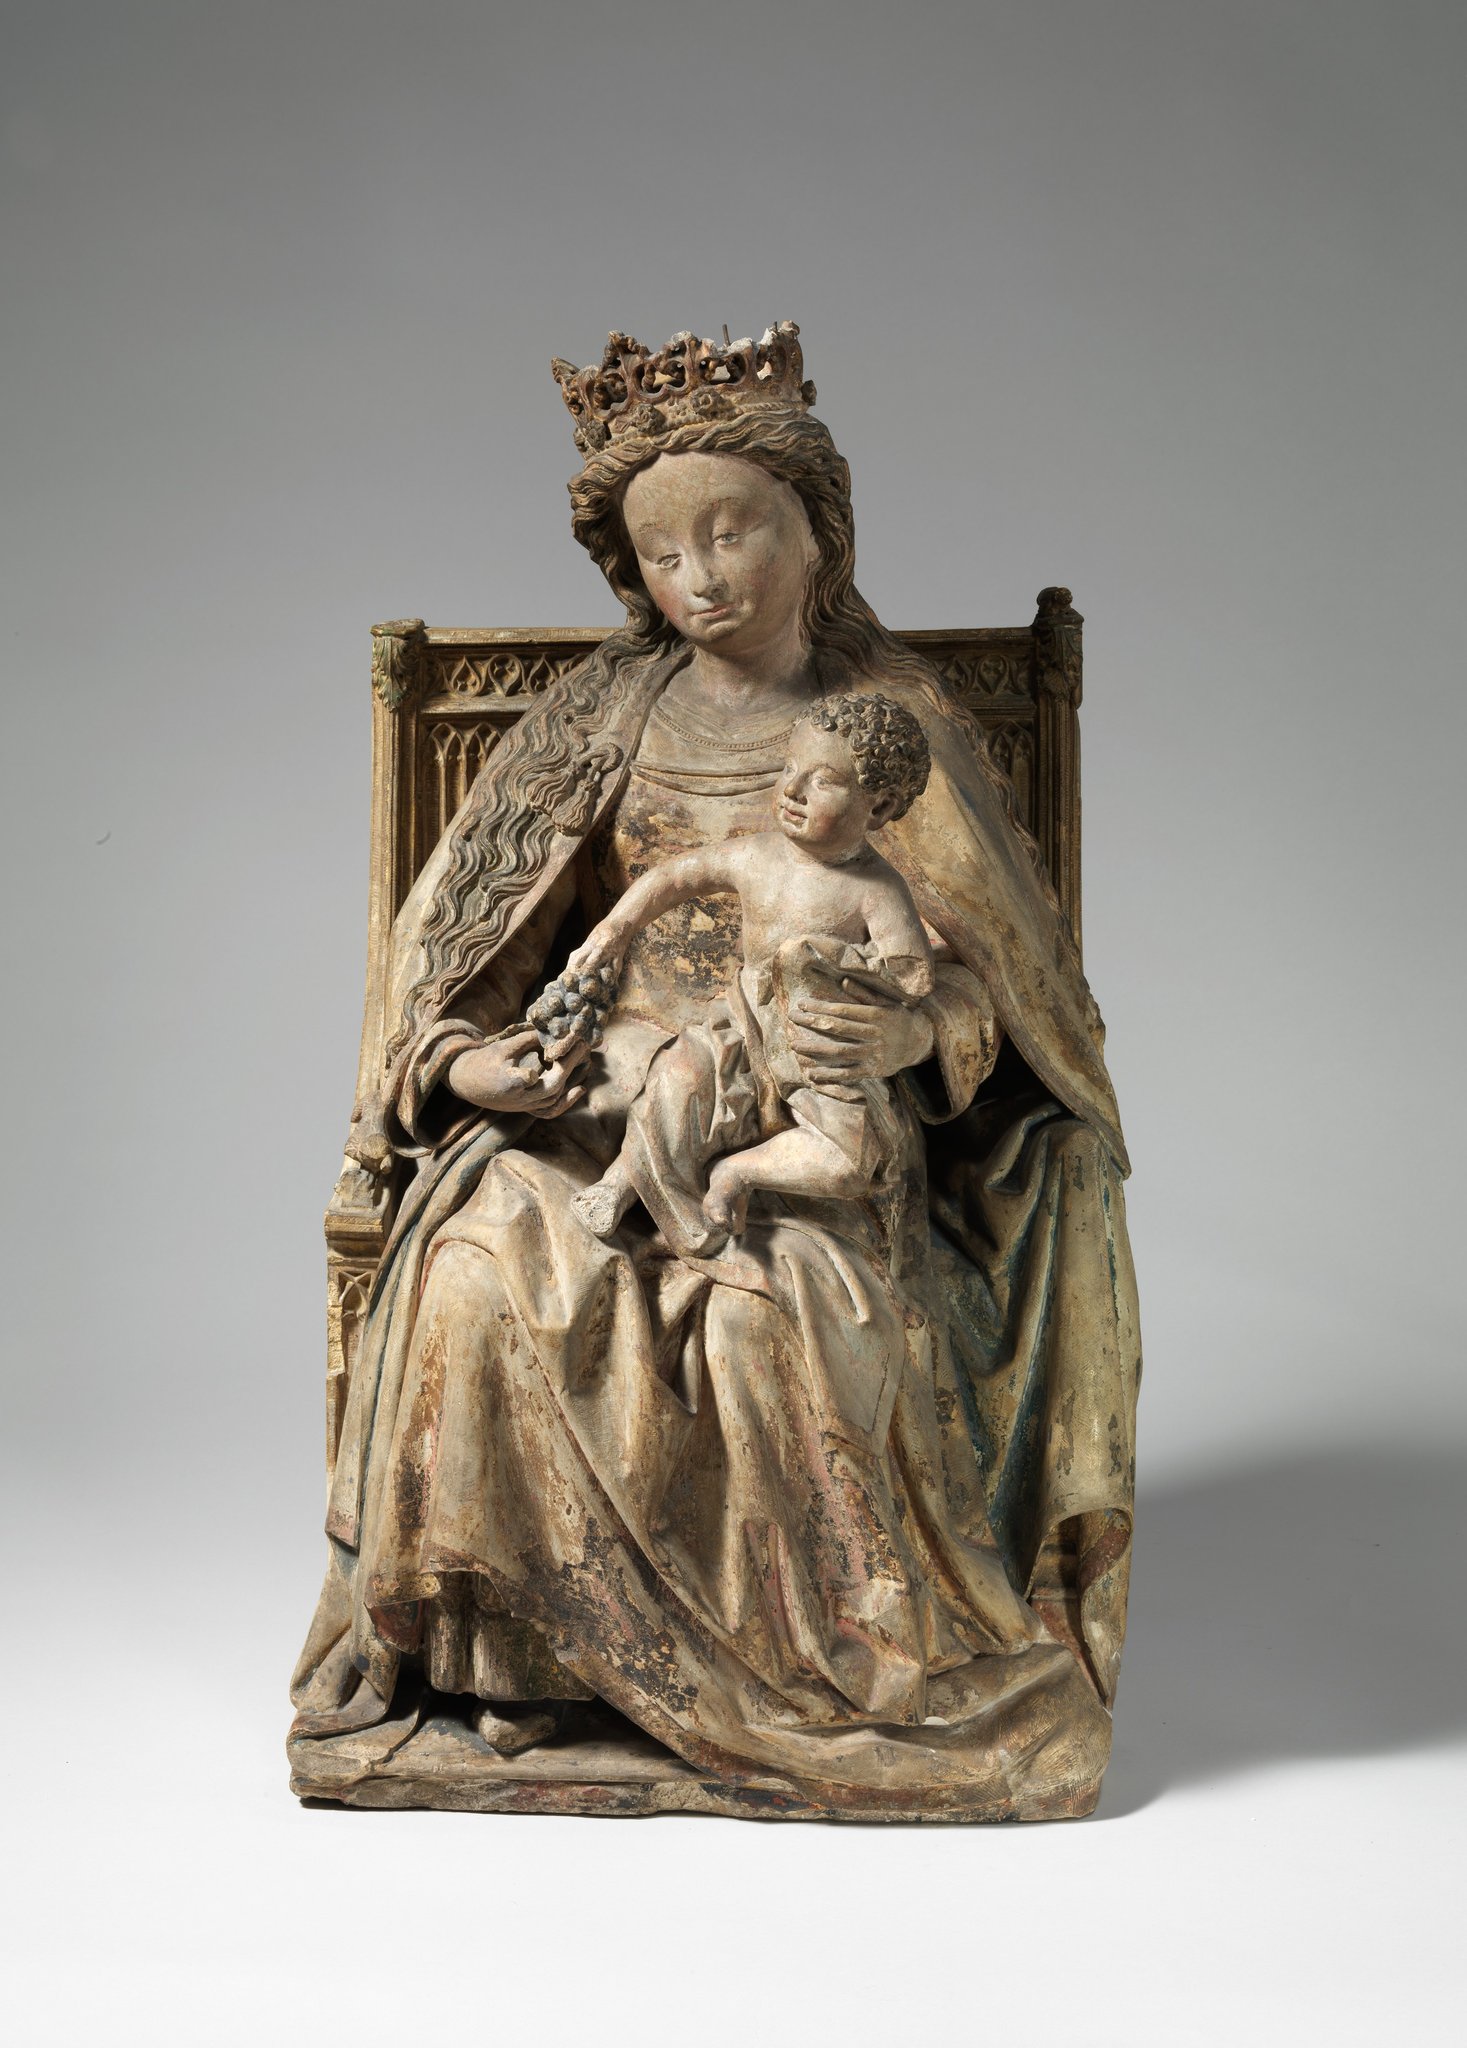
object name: sculpture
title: Virgin and Child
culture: french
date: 1501-1533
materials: limestone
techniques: polychromy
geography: troyes